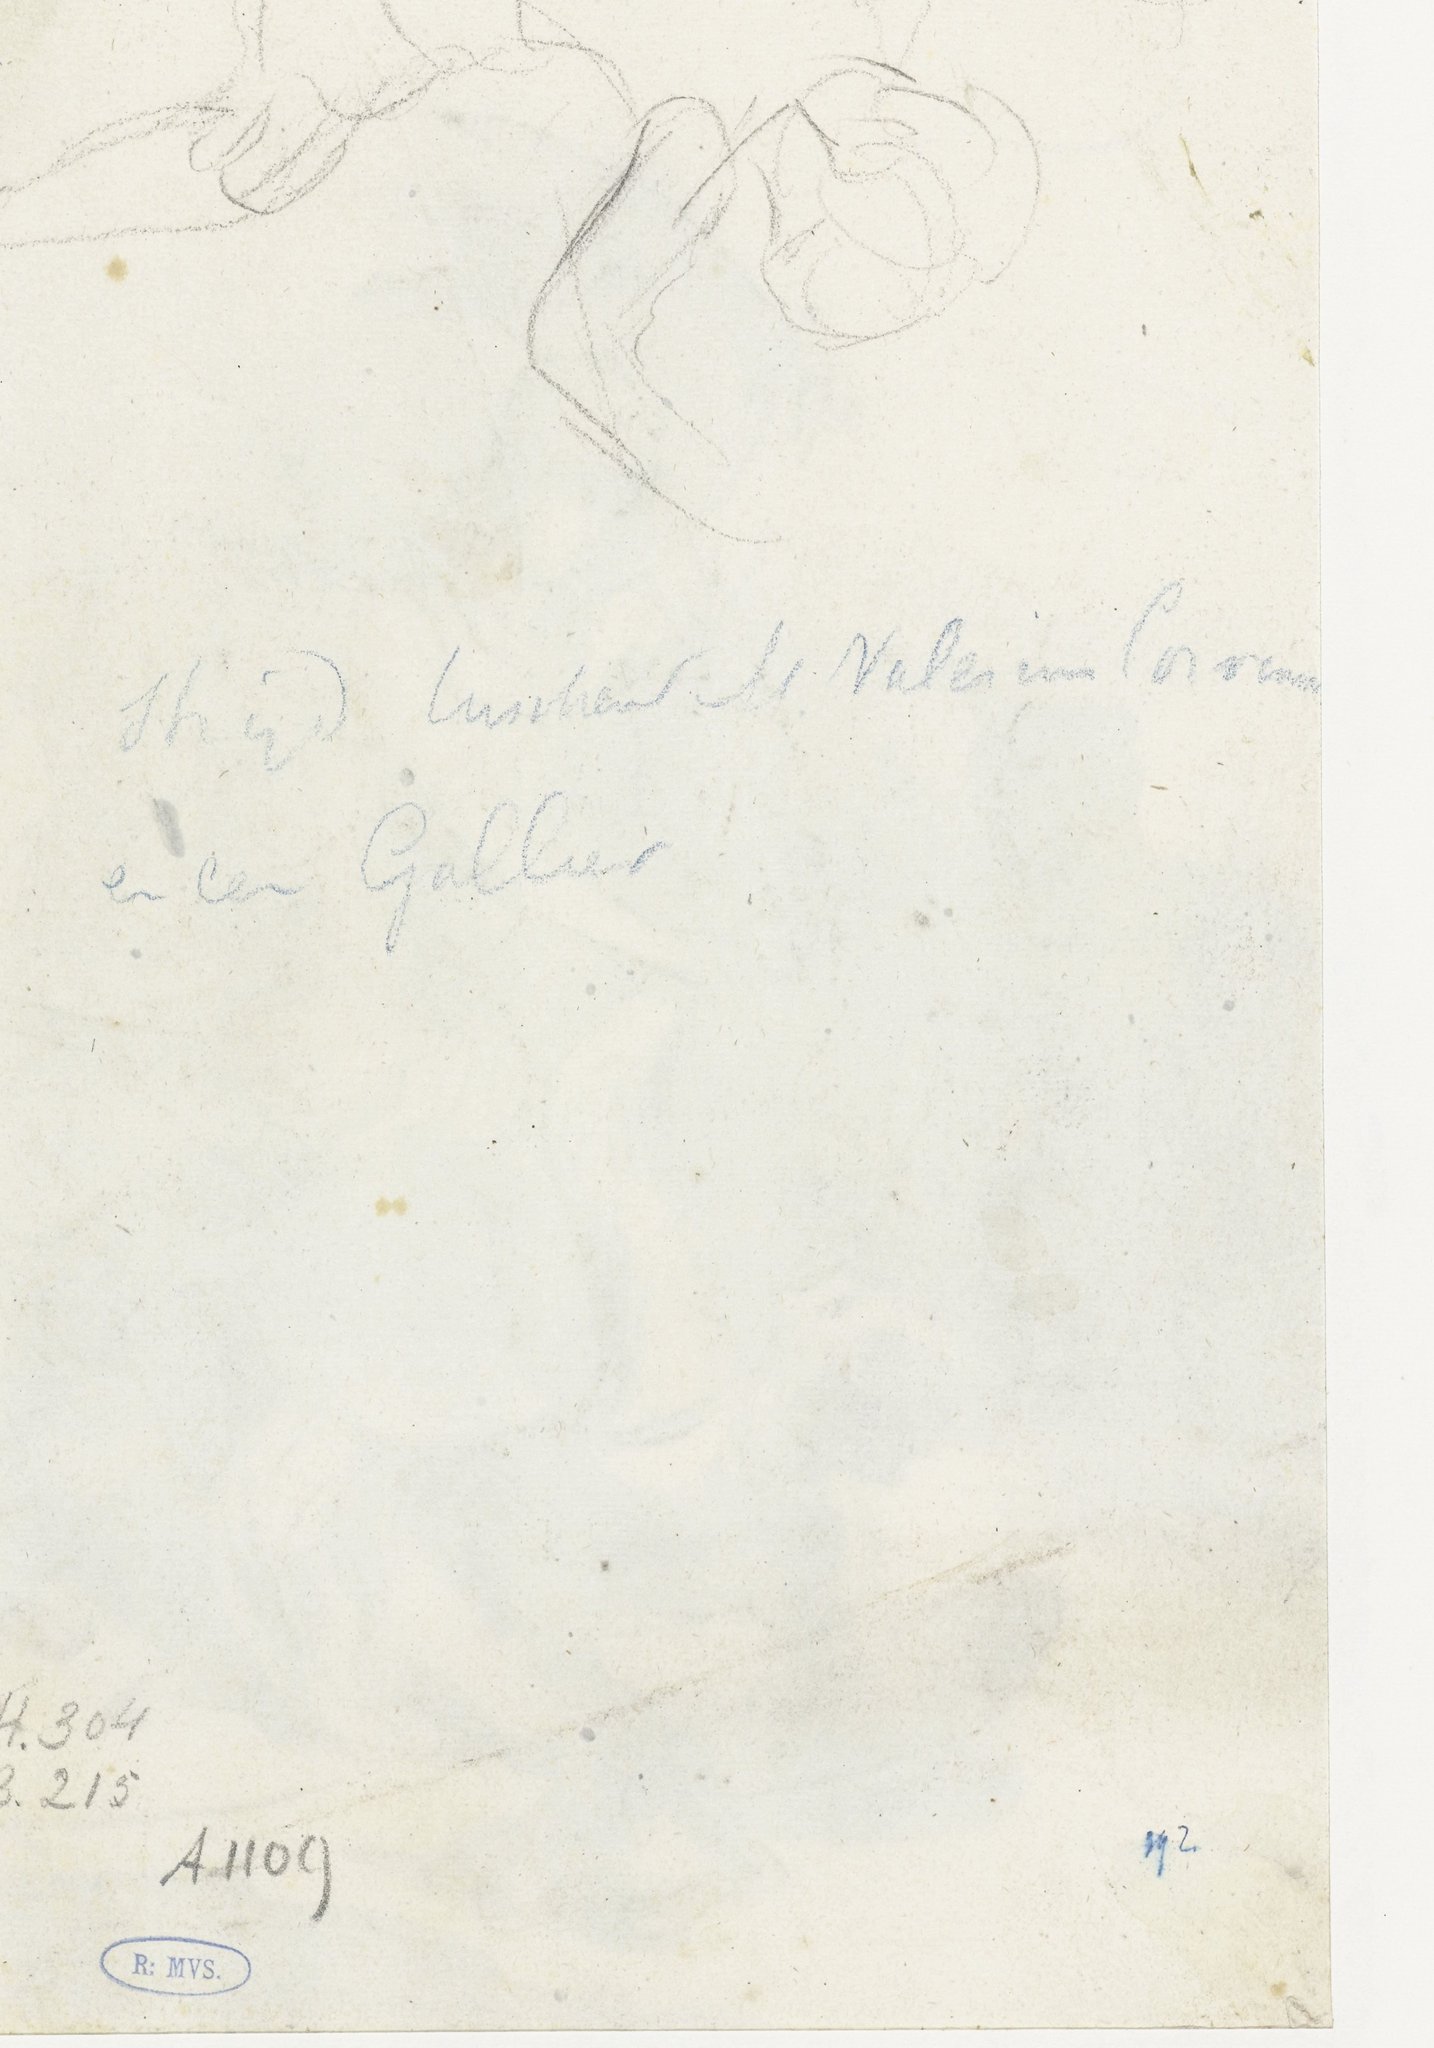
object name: drawing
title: Schets van Galliër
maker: moses ter borch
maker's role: draughtsman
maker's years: 1645-1667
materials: chalk, paper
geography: zwolle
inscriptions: annotation: ‘strijd tuschen M.Valerius Corvinus en een Gallier’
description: Voorstudie voor gevallen Galliër op recto.